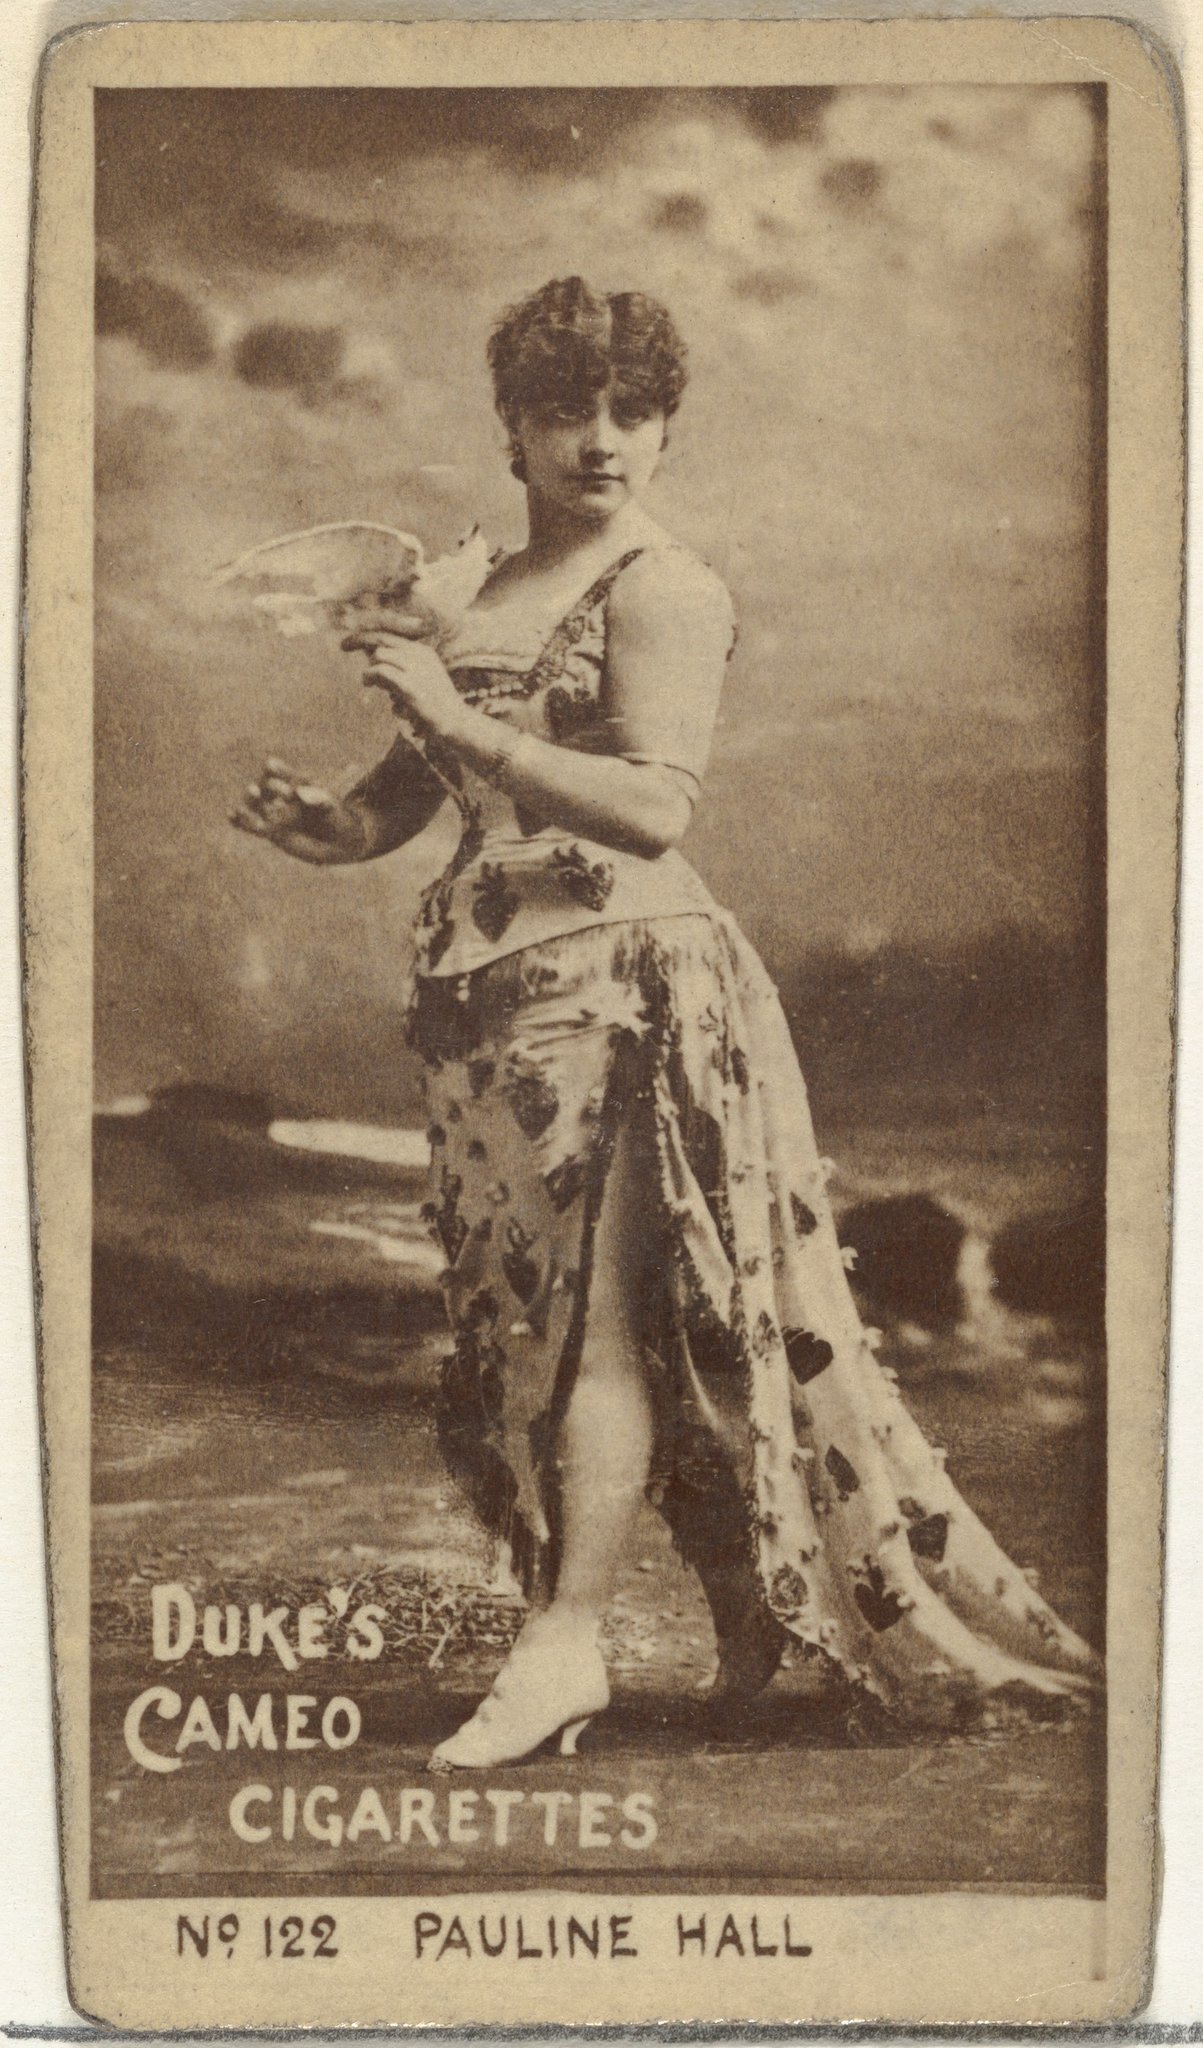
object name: photograph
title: Card Number 122, Pauline Hall, from the Actors and Actresses series (N145-4) issued by Duke Sons & Co. to promote Cameo Cigarettes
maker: w. duke, sons & co.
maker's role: publisher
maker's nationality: american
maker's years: 1870-1920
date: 1880-1889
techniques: albumen silver print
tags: portraits,women,actresses